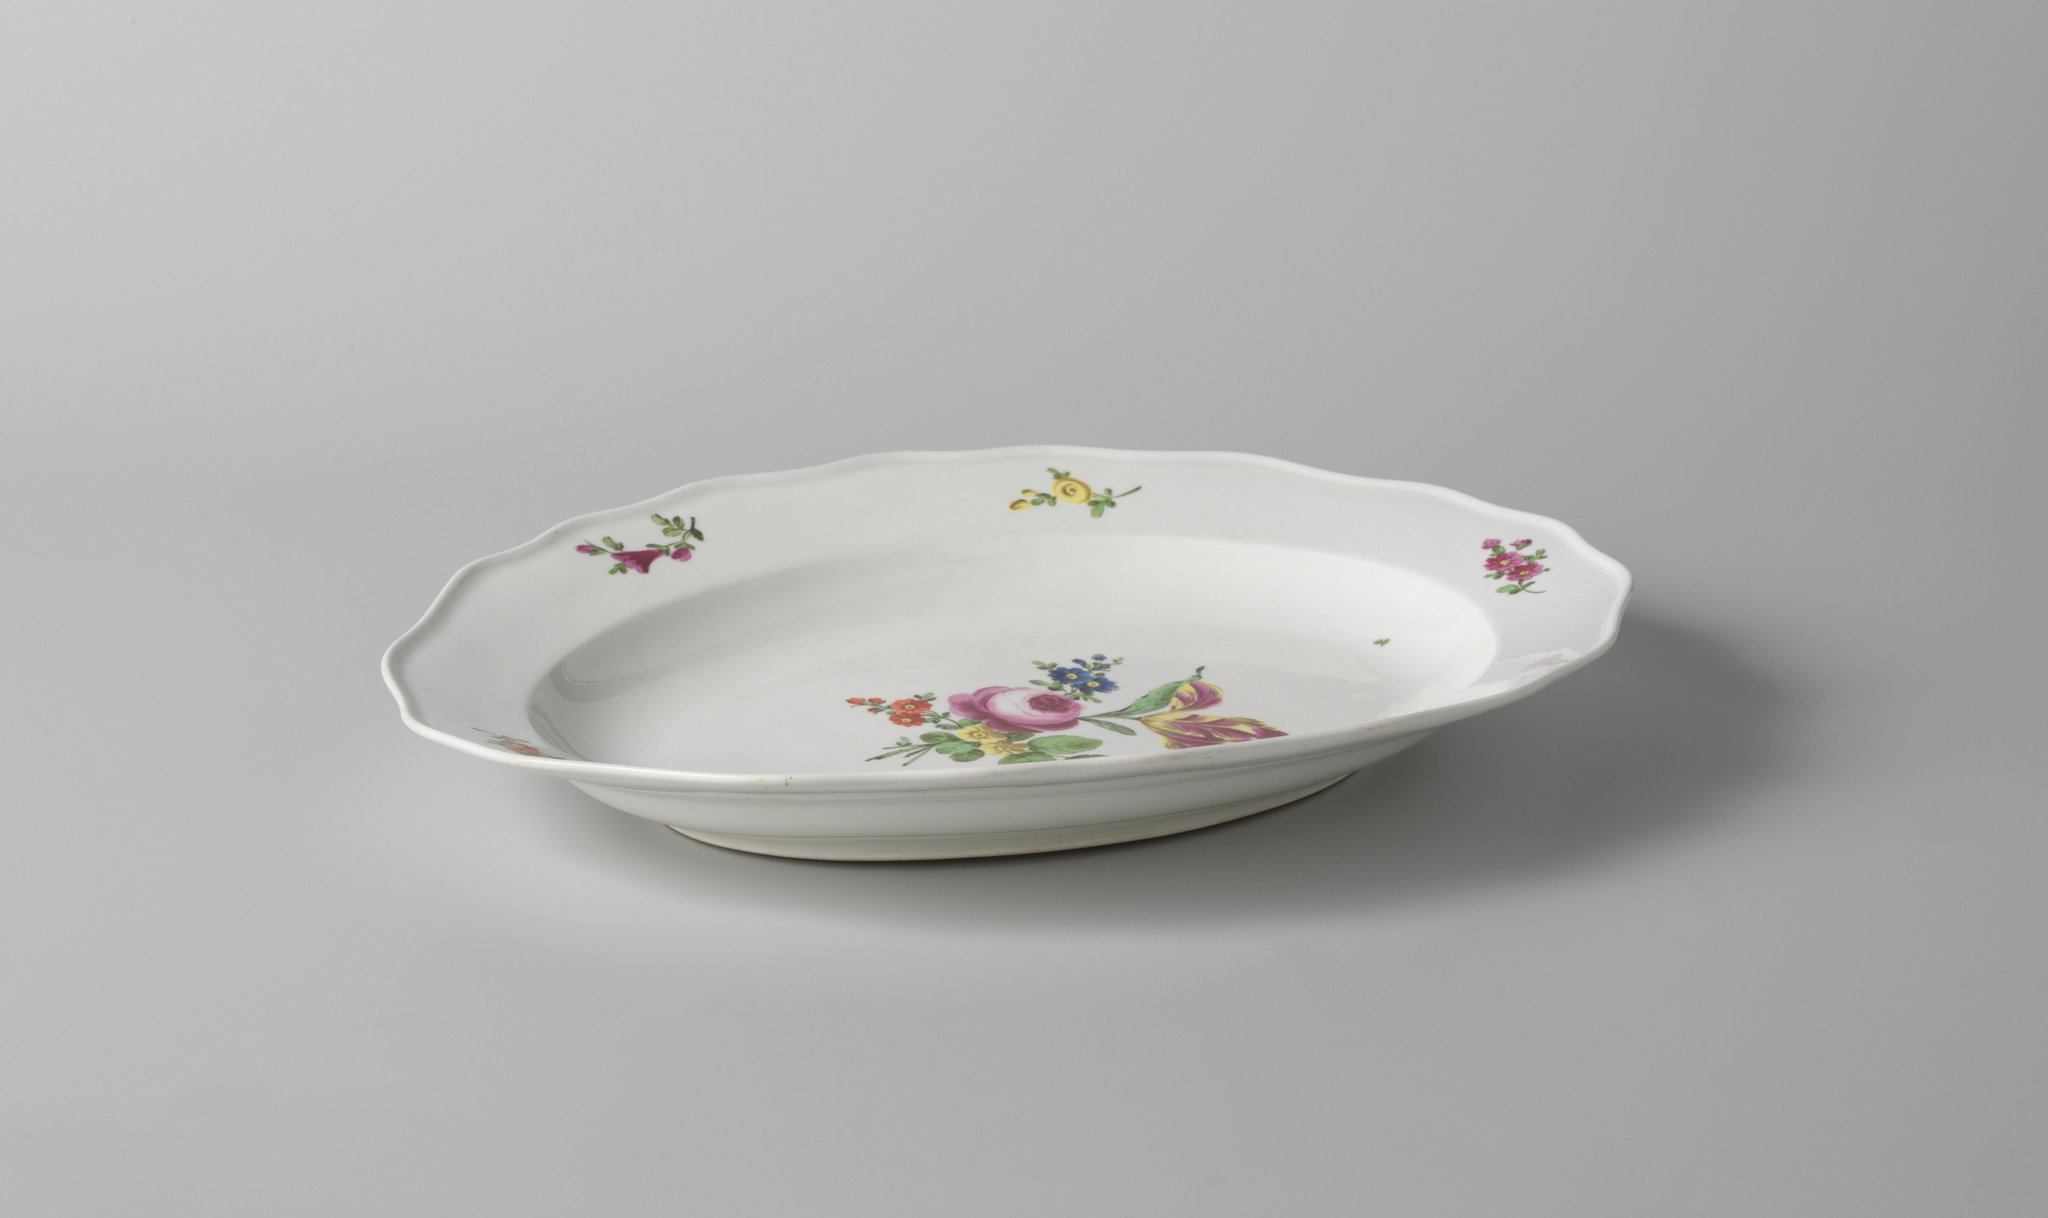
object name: platter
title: Dish with a bouquet and flower sprays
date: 1800-1849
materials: glaze, paint, porcelain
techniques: firing, forming, turning, vitrification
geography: vienna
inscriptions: mark: ‘schild’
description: Ovale schotel van porselein met gelobde rand, beschilderd op het glazuur in rood, roze, groen, geel en paars. Op het plat een boeket van verschillende bloemen (o.a. pioenroos) omgeven door losse takjes en op de rand zes bloemtakken. Gemerkt op de onderzijde met het schild.